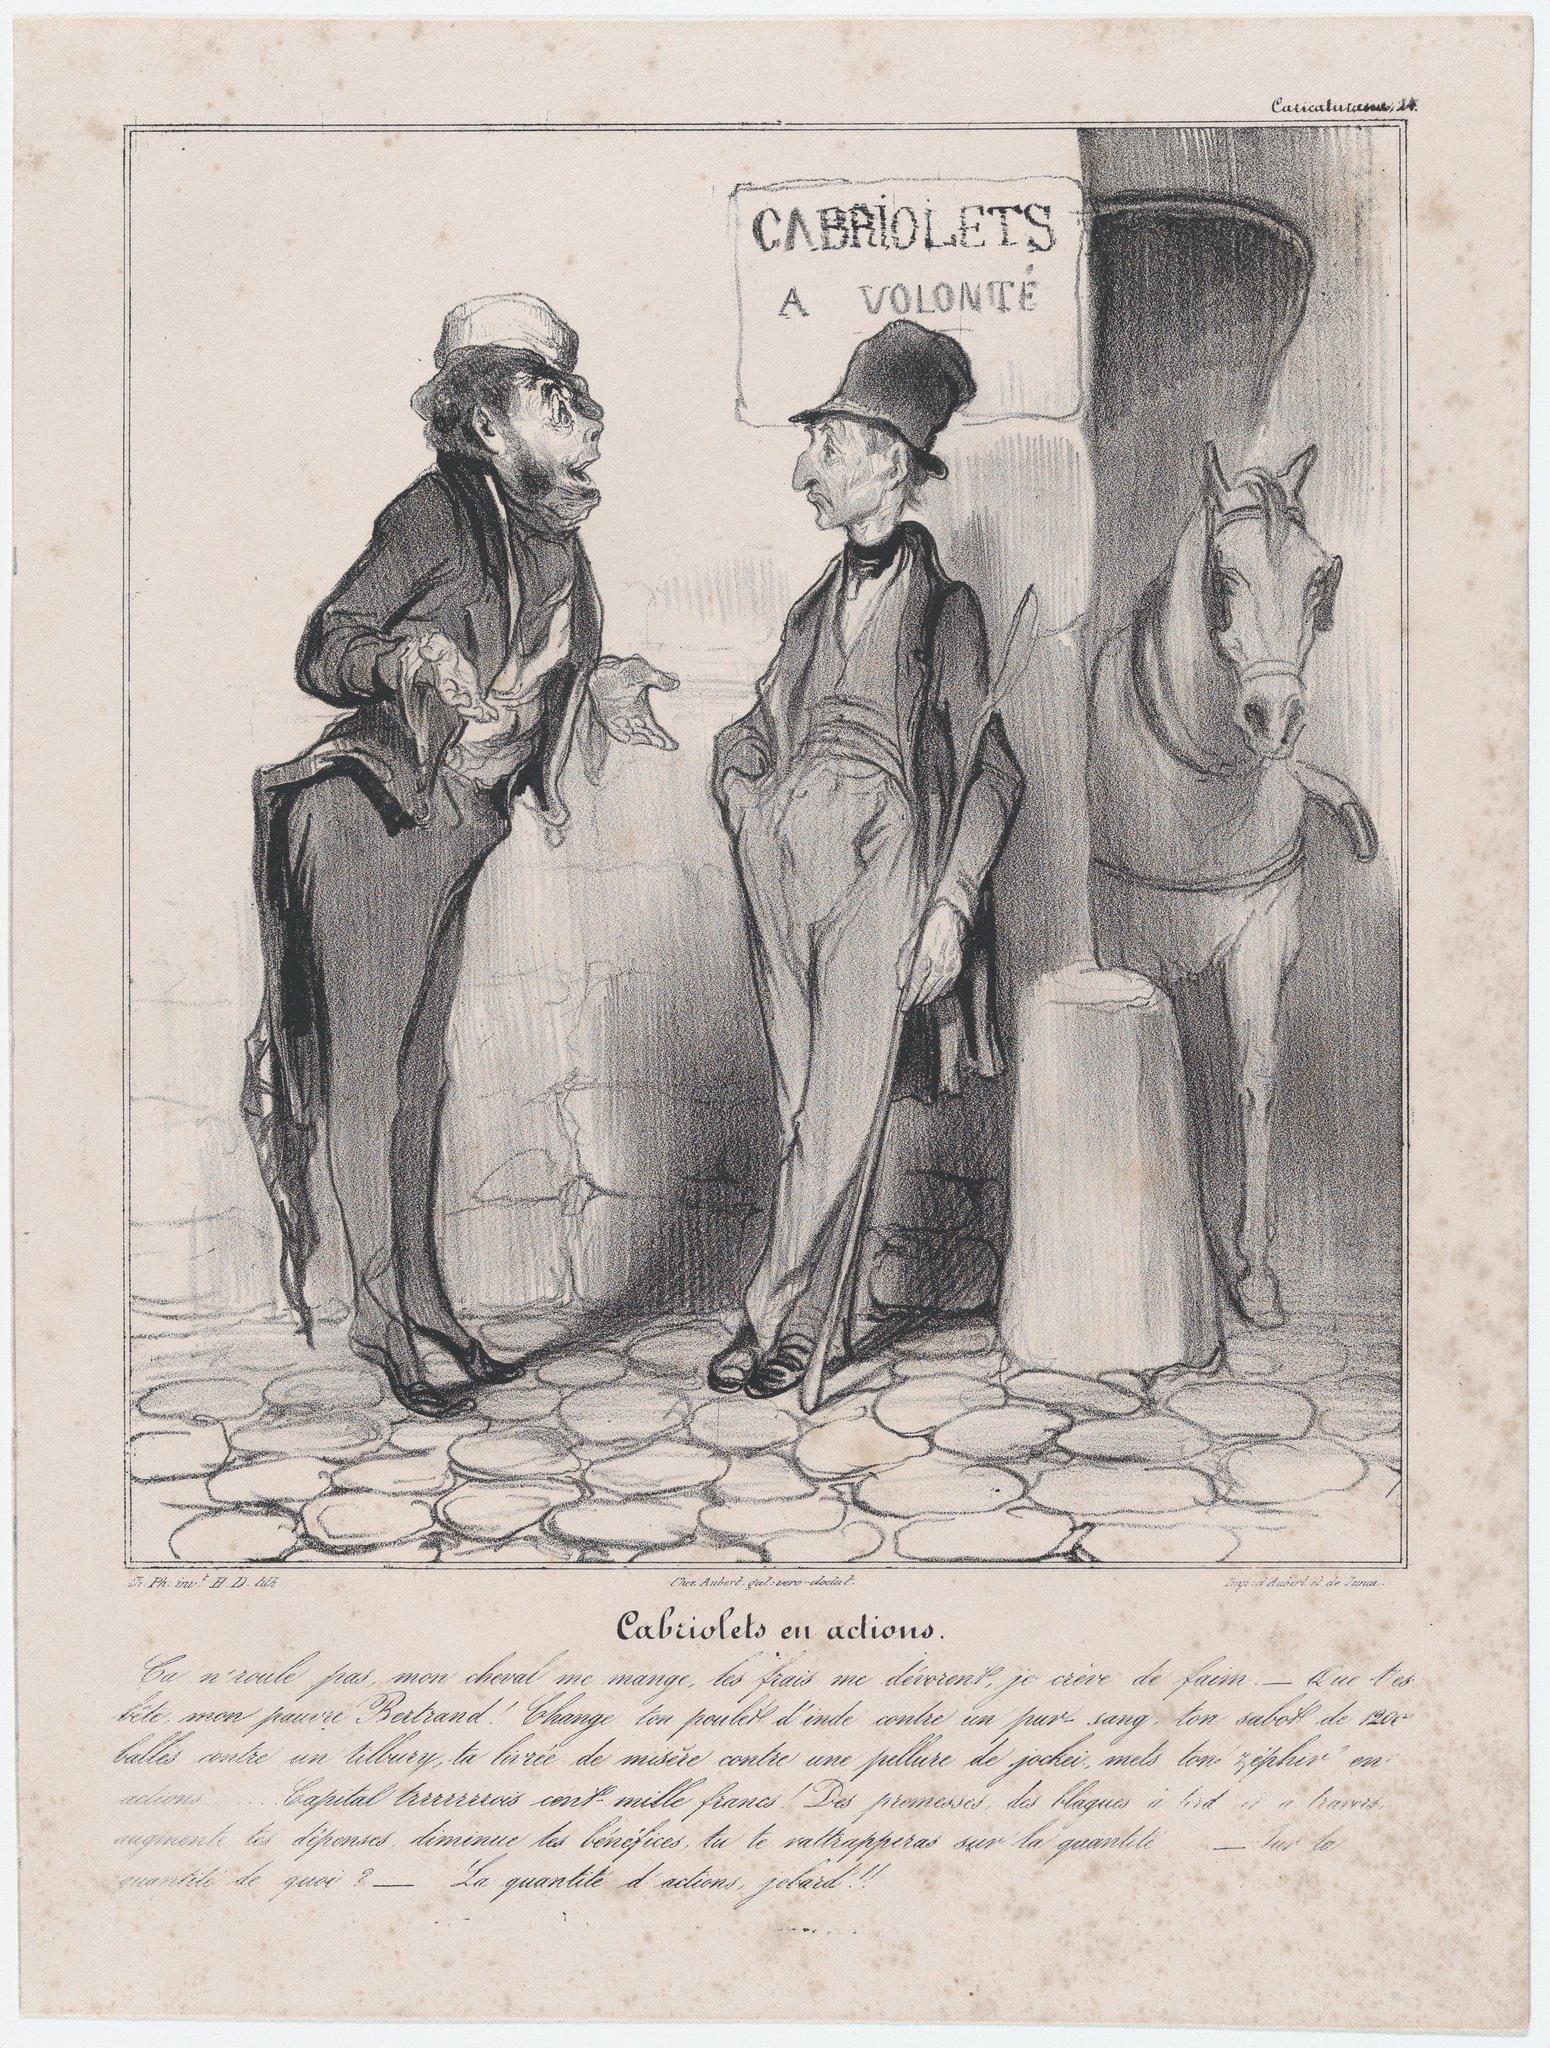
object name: print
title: Plate 24: Gigs in action, from 'Caricaturana,' published in Les Robert Macaires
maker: honoré daumier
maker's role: artist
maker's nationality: french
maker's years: 1808-1879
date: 1838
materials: paper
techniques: lithograph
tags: men,horses